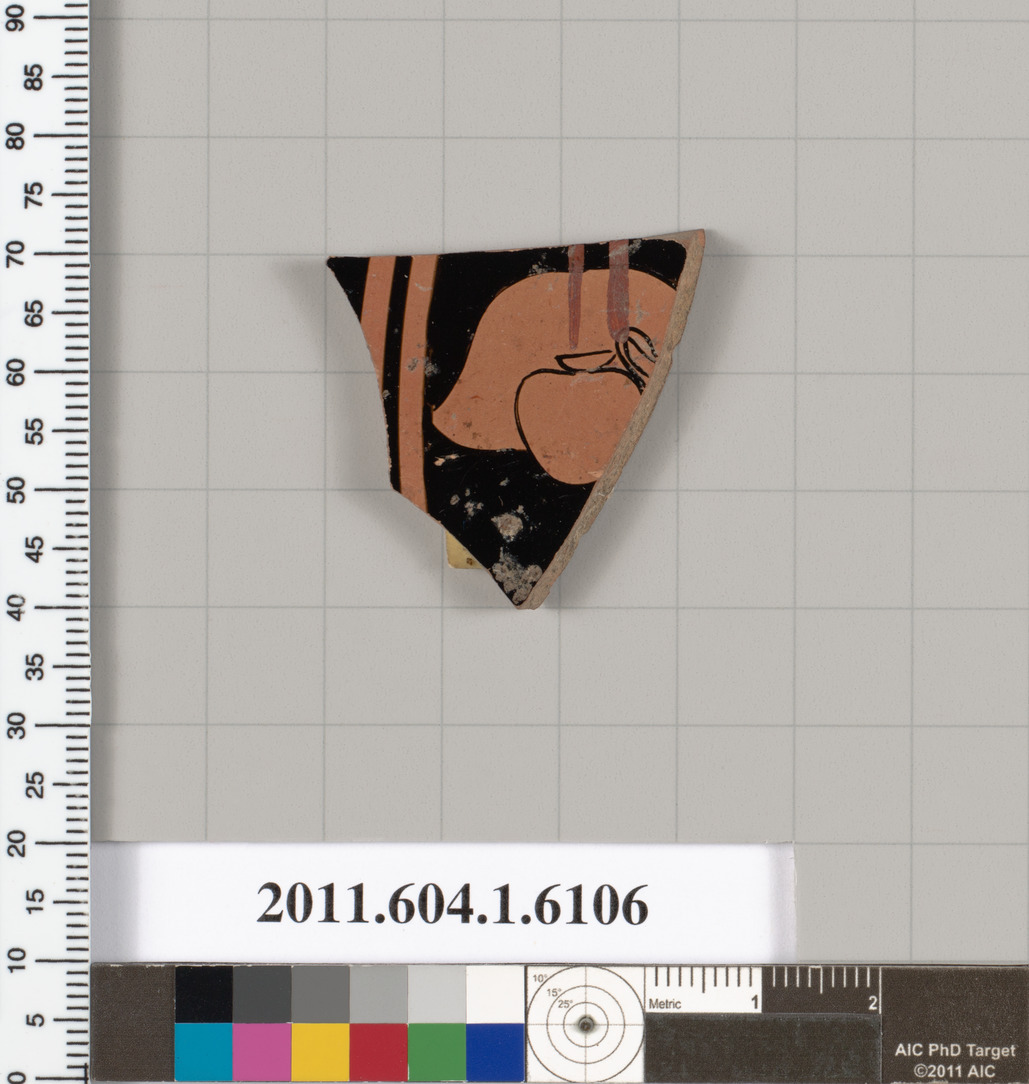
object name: kylix fragment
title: Terracotta fragment of a kylix (drinking cup)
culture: greek, attic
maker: apollodoros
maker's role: artist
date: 500-490 BCE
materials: terracotta